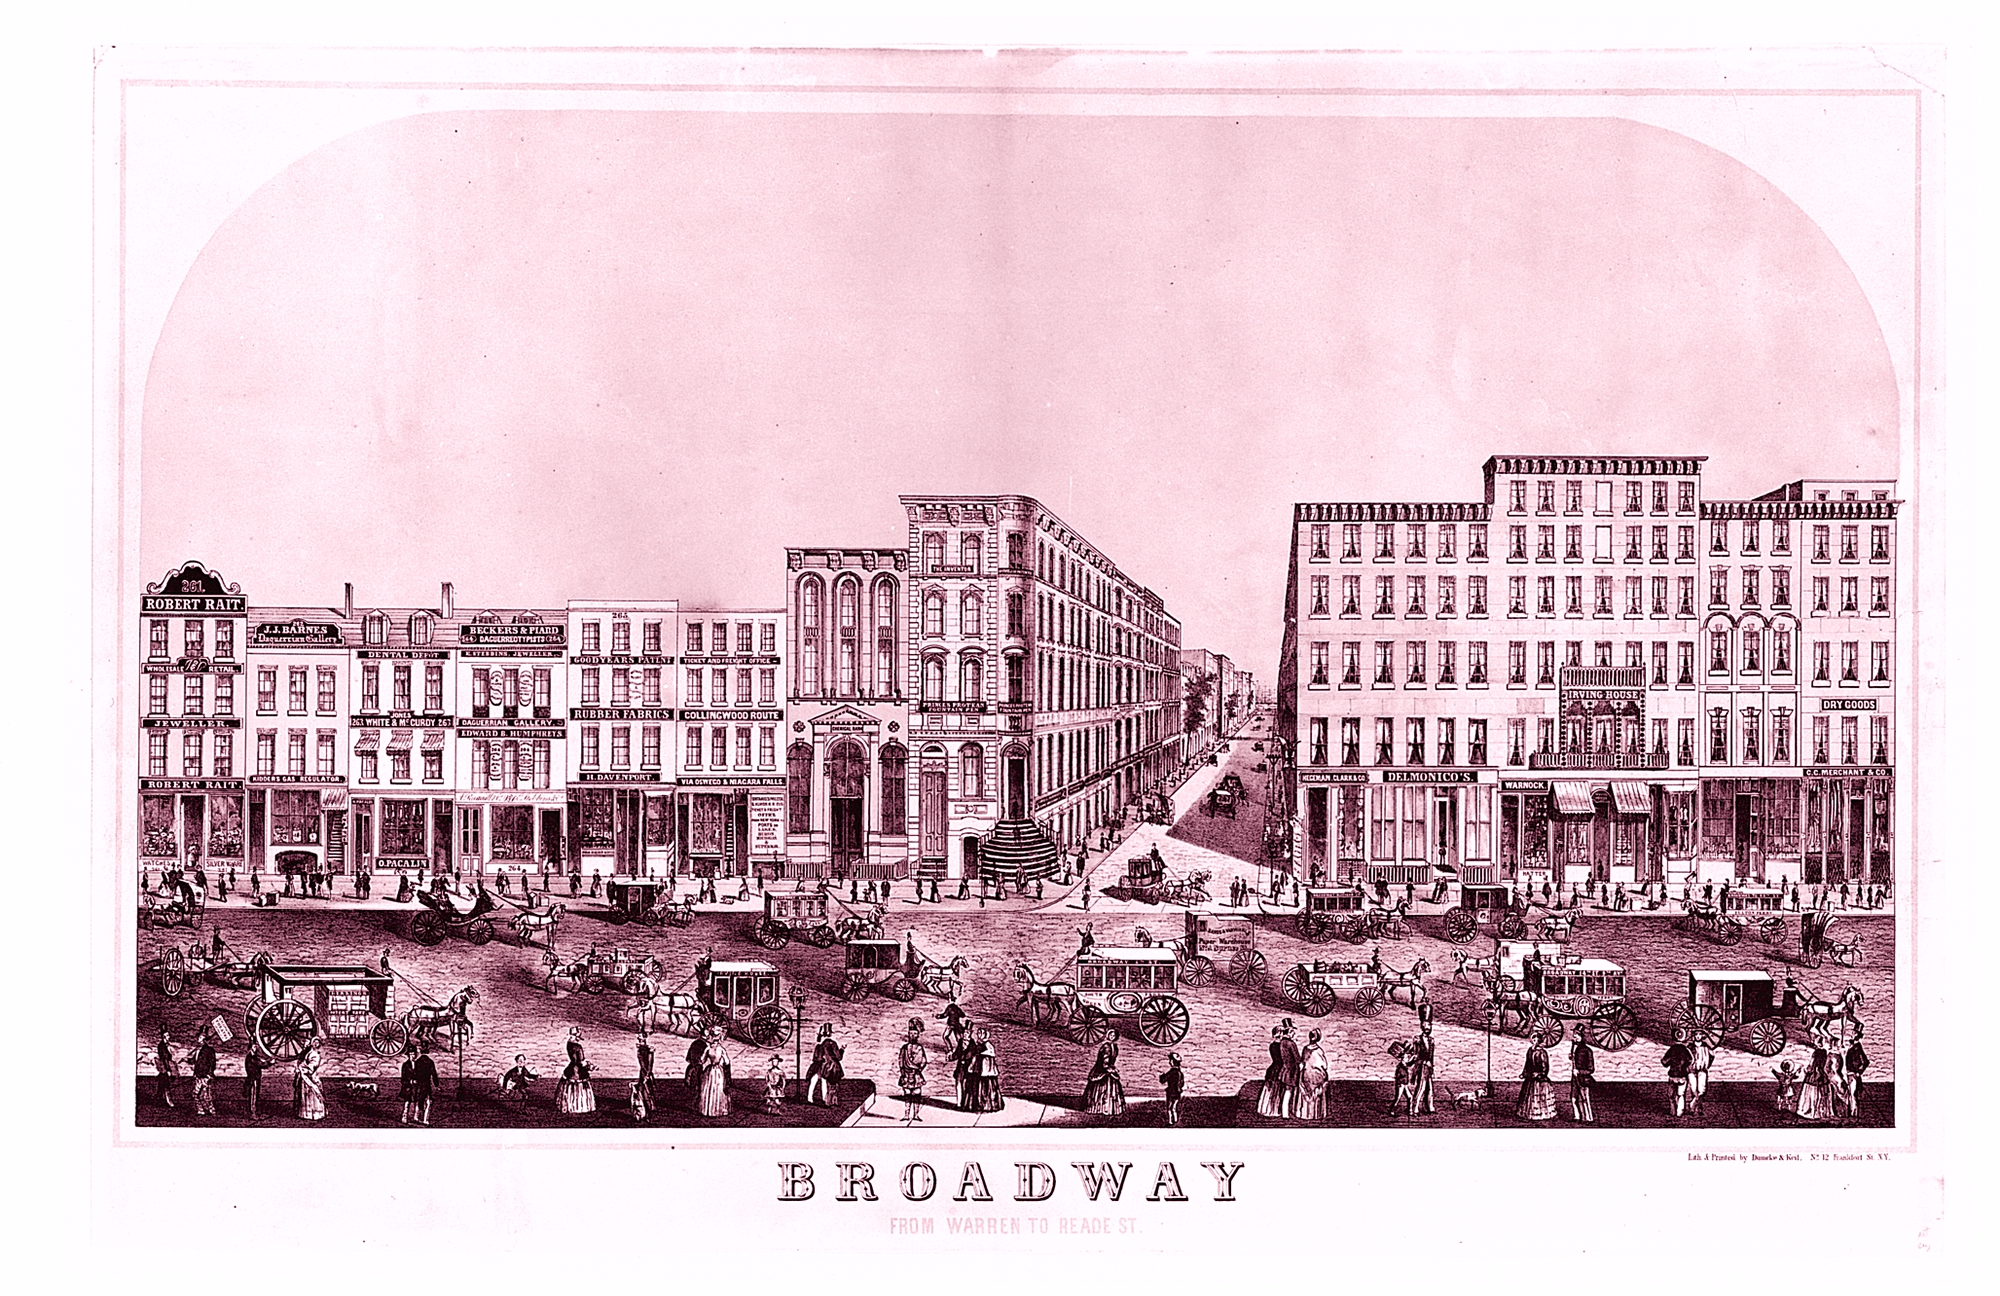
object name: print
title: Broadway, New York from Warren to Reade Street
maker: dumcke and keil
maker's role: lithographer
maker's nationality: american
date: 1855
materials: stone, watercolor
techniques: lithograph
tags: buildings,cities,streets,horses,carriages,new york city